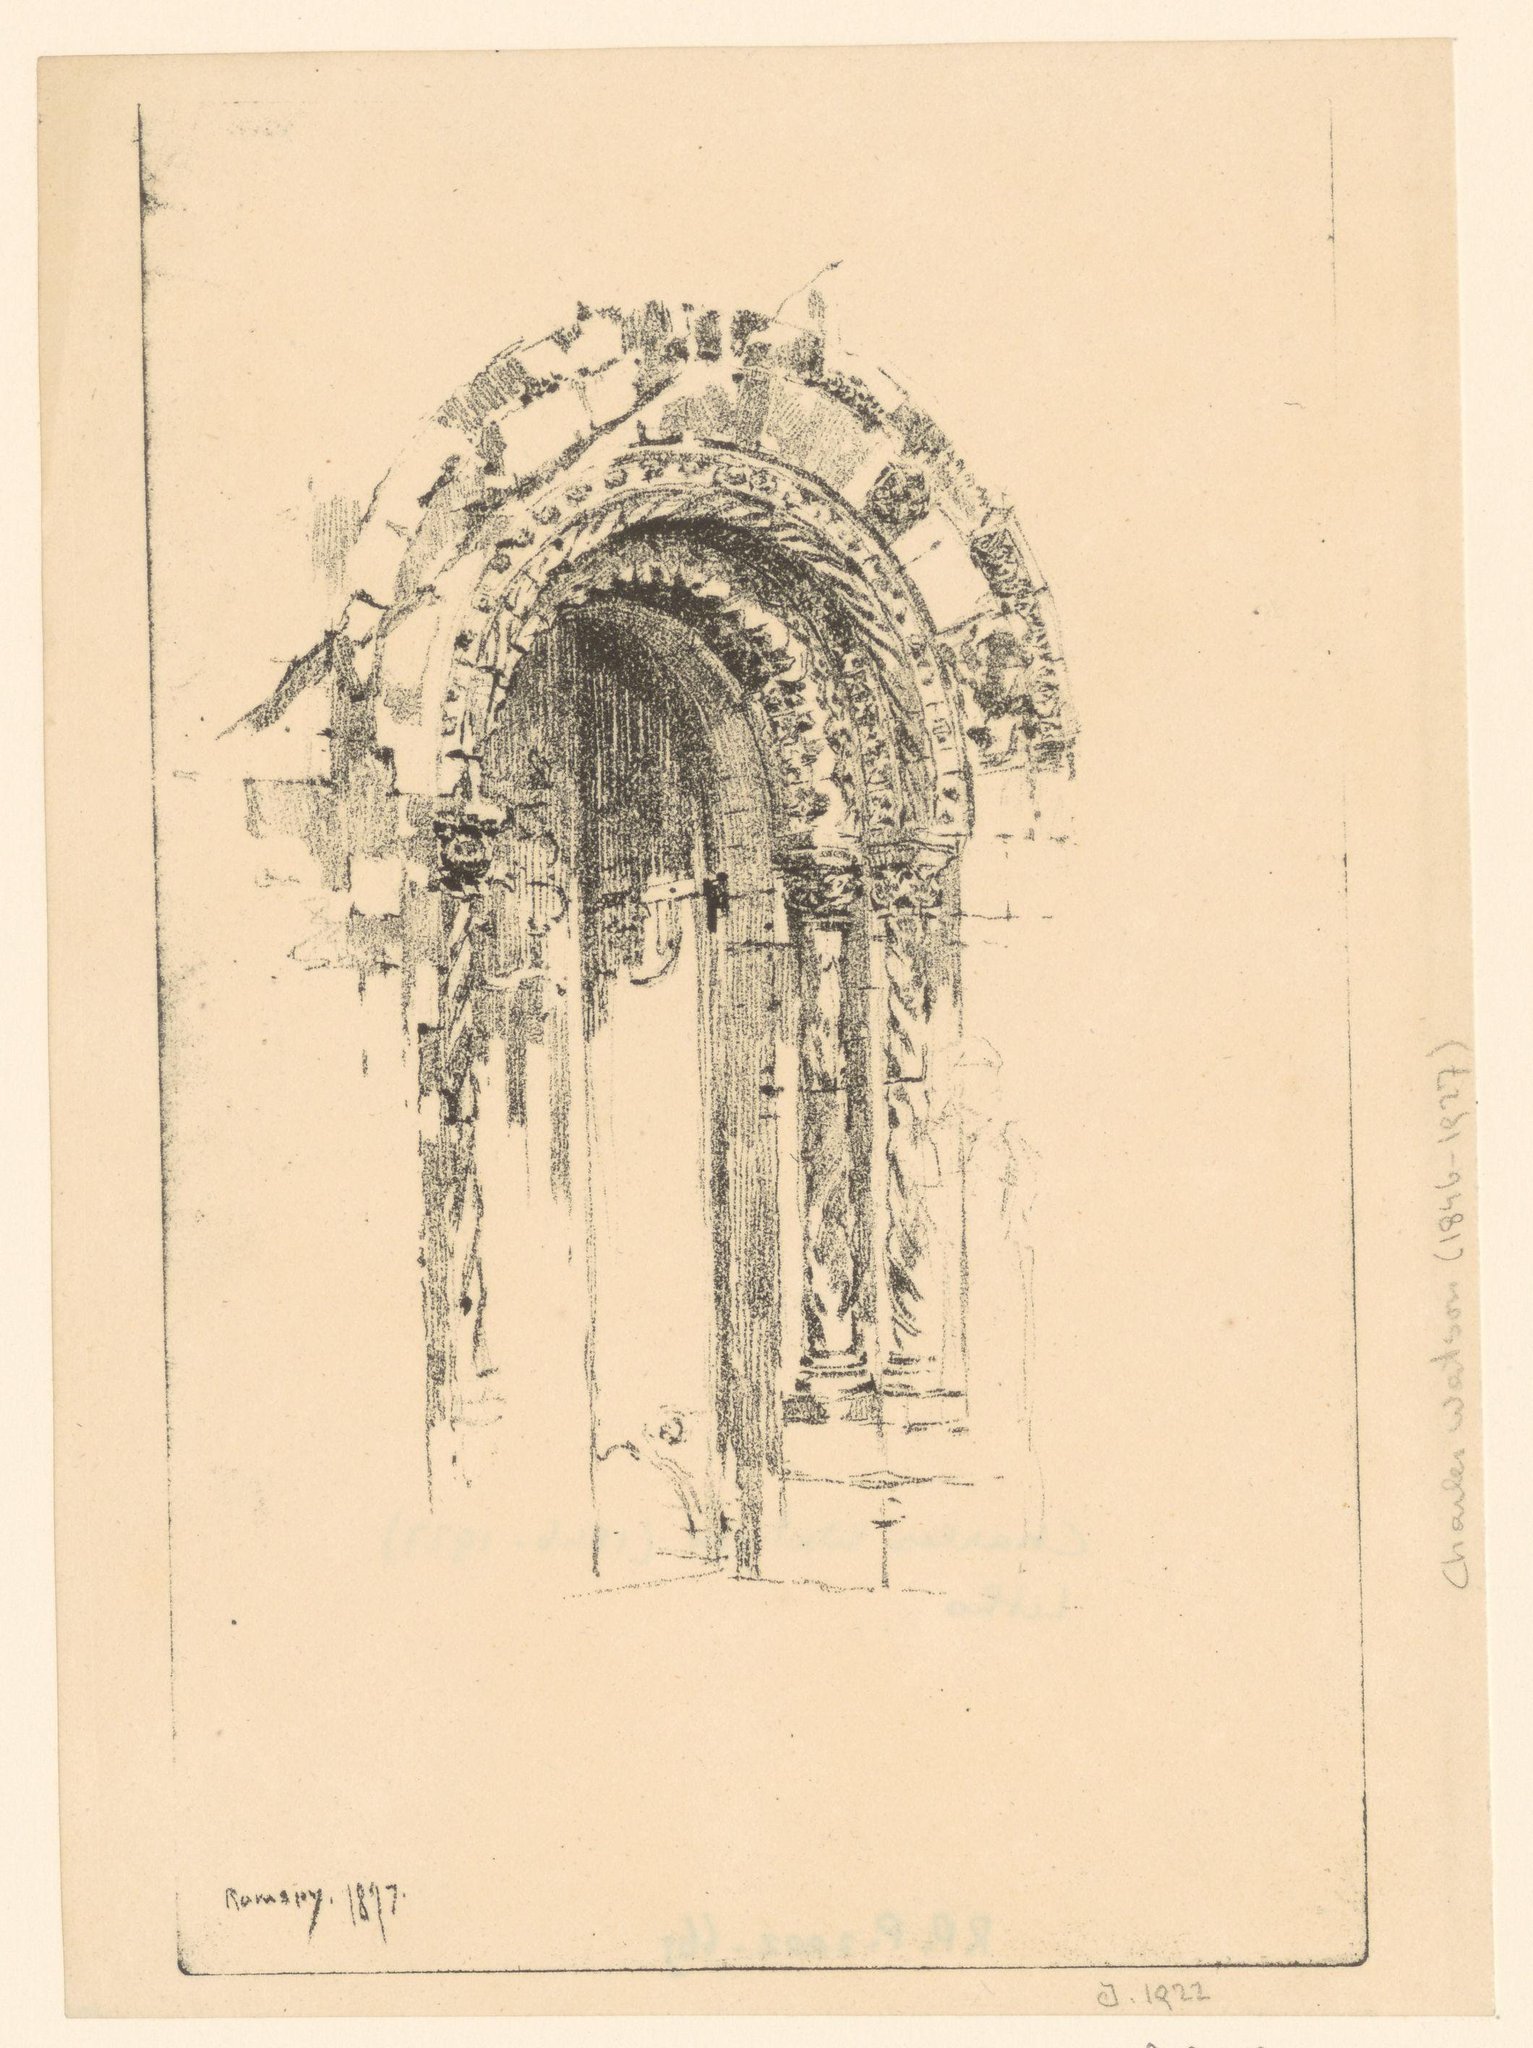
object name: print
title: Romsey 1897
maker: charles john watson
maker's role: print maker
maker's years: 1846-1927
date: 1897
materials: paper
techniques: lithograph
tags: parts of church exterior and annexes: portal, abbey, monastery, convent ~ roman catholic church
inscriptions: collector's mark: Lugt 2228